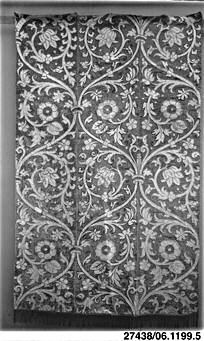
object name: hanging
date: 1567-1600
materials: linen, silk